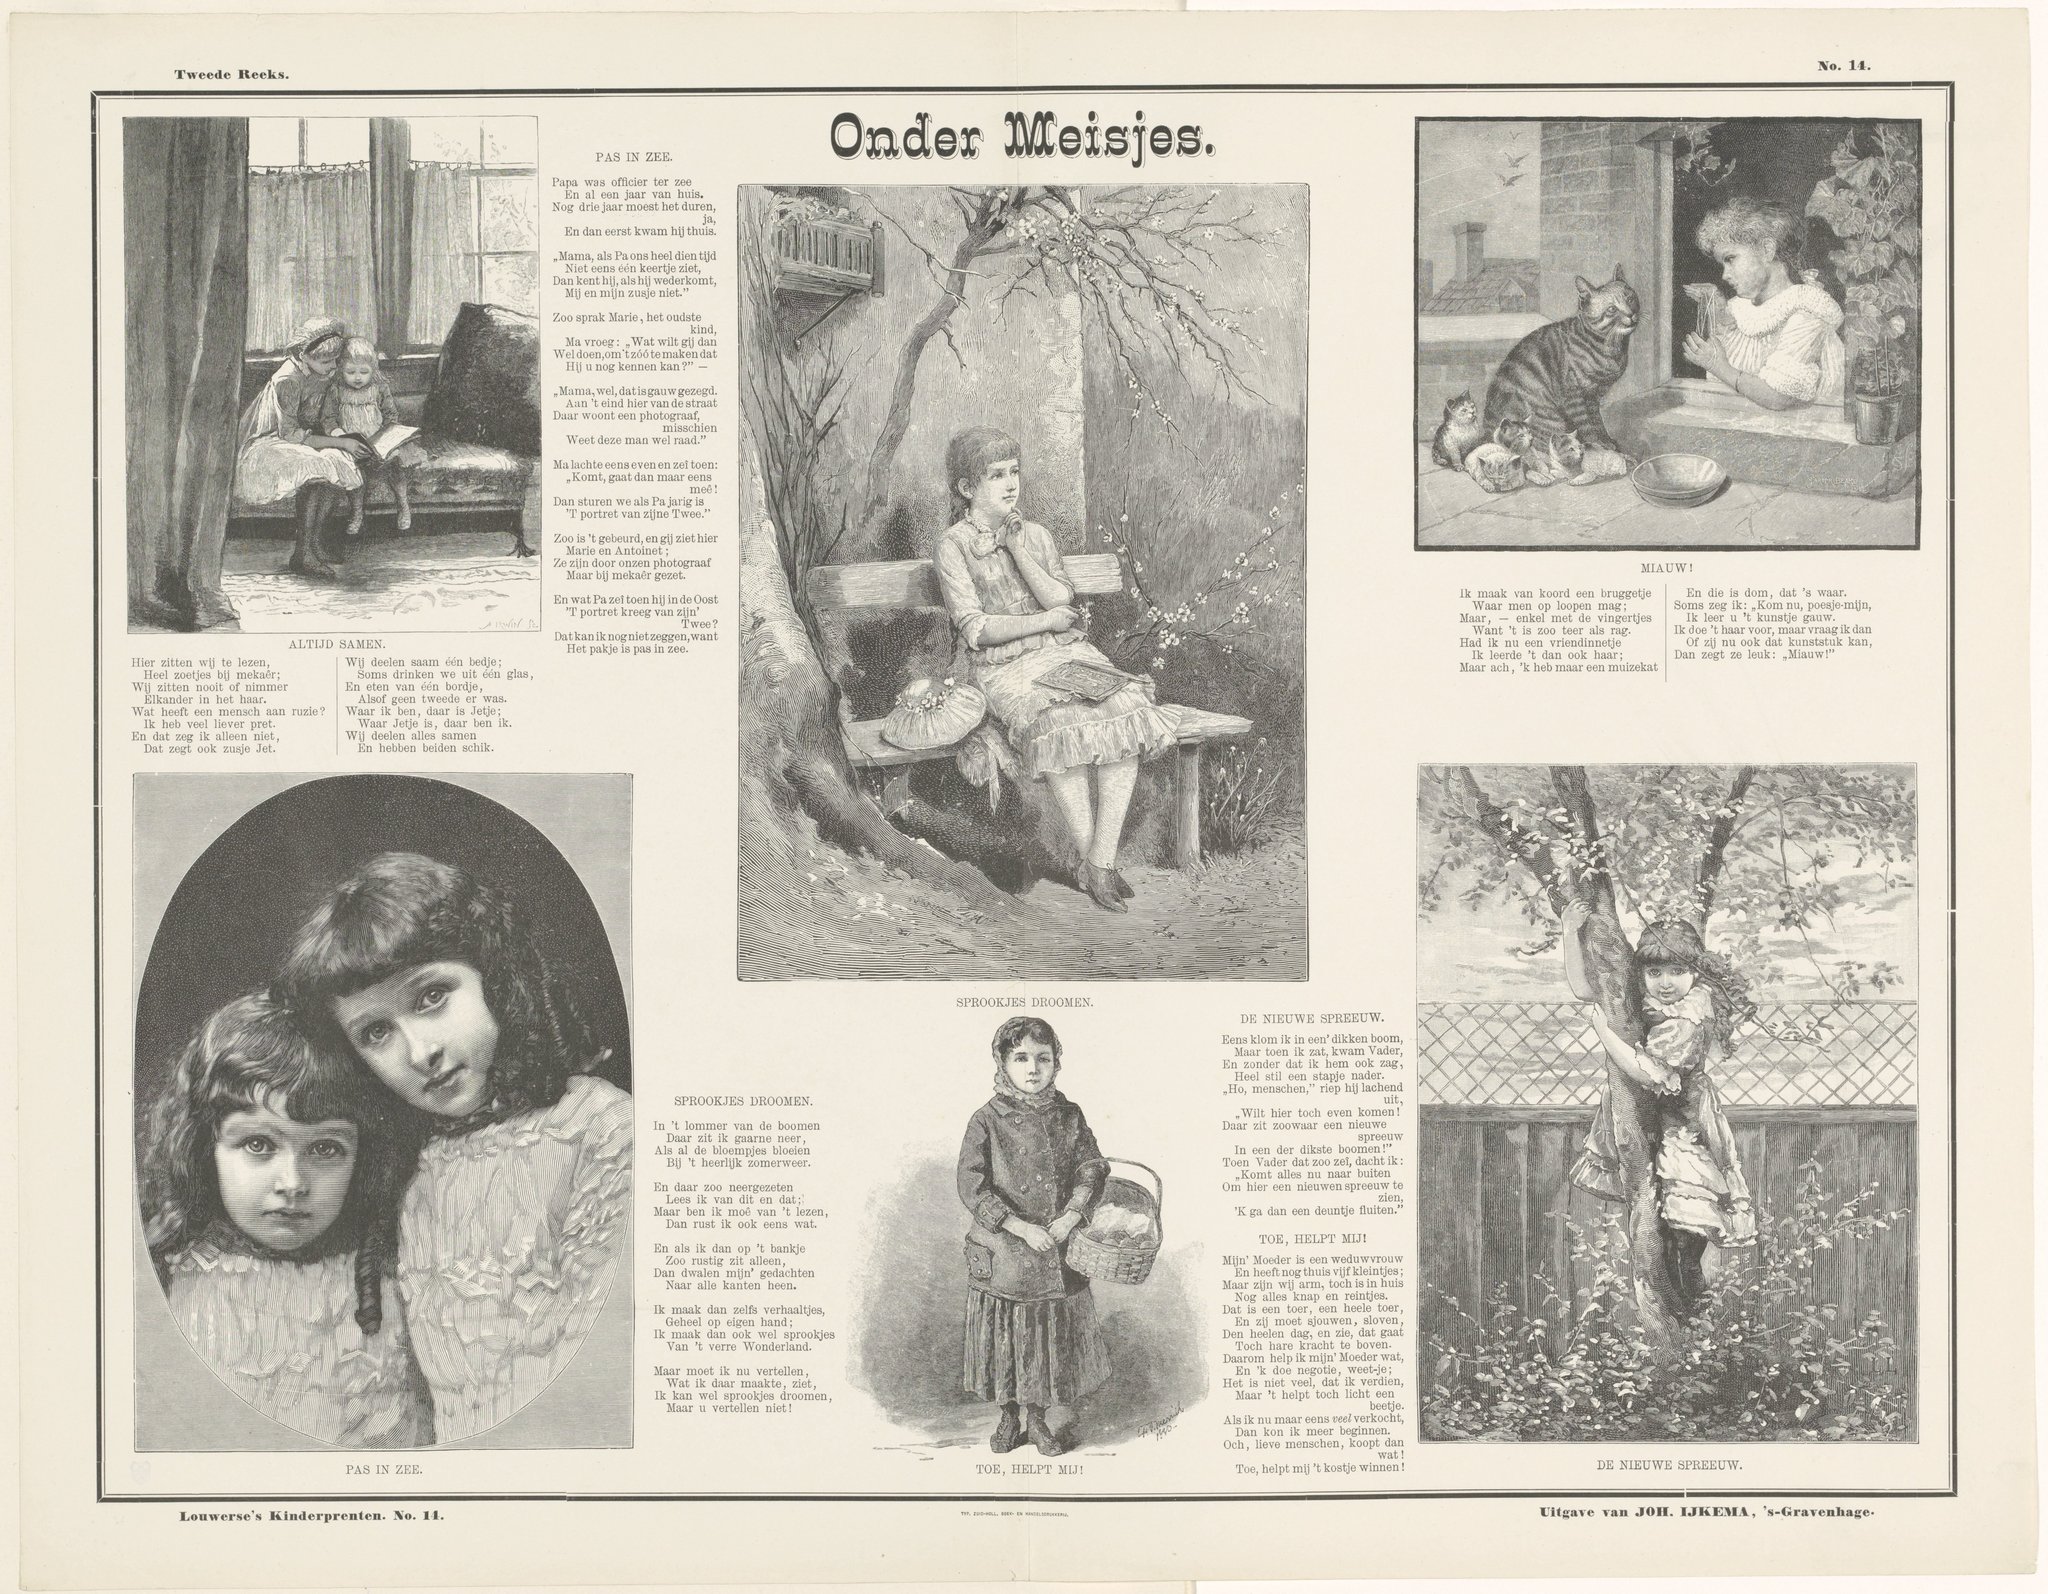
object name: print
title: Tweede reeks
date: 1887-1905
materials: paper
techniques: letterpress printing, printing block, engraving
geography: the hague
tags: girl (child between toddler and youth)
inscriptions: collector's mark: Lugt 2760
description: Blad met 6 voorstellingen van meisjes. Tussen de afbeeldingen versjes in boekdruk. Genummerd rechtsboven en linksonder: No. 14.